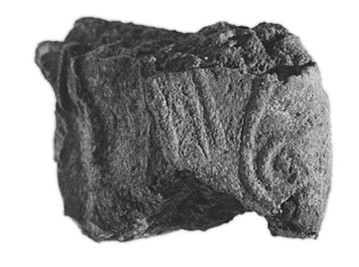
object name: sealing, administrative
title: Administrative Seal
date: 1981-1640 BCE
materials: clay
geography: egypt